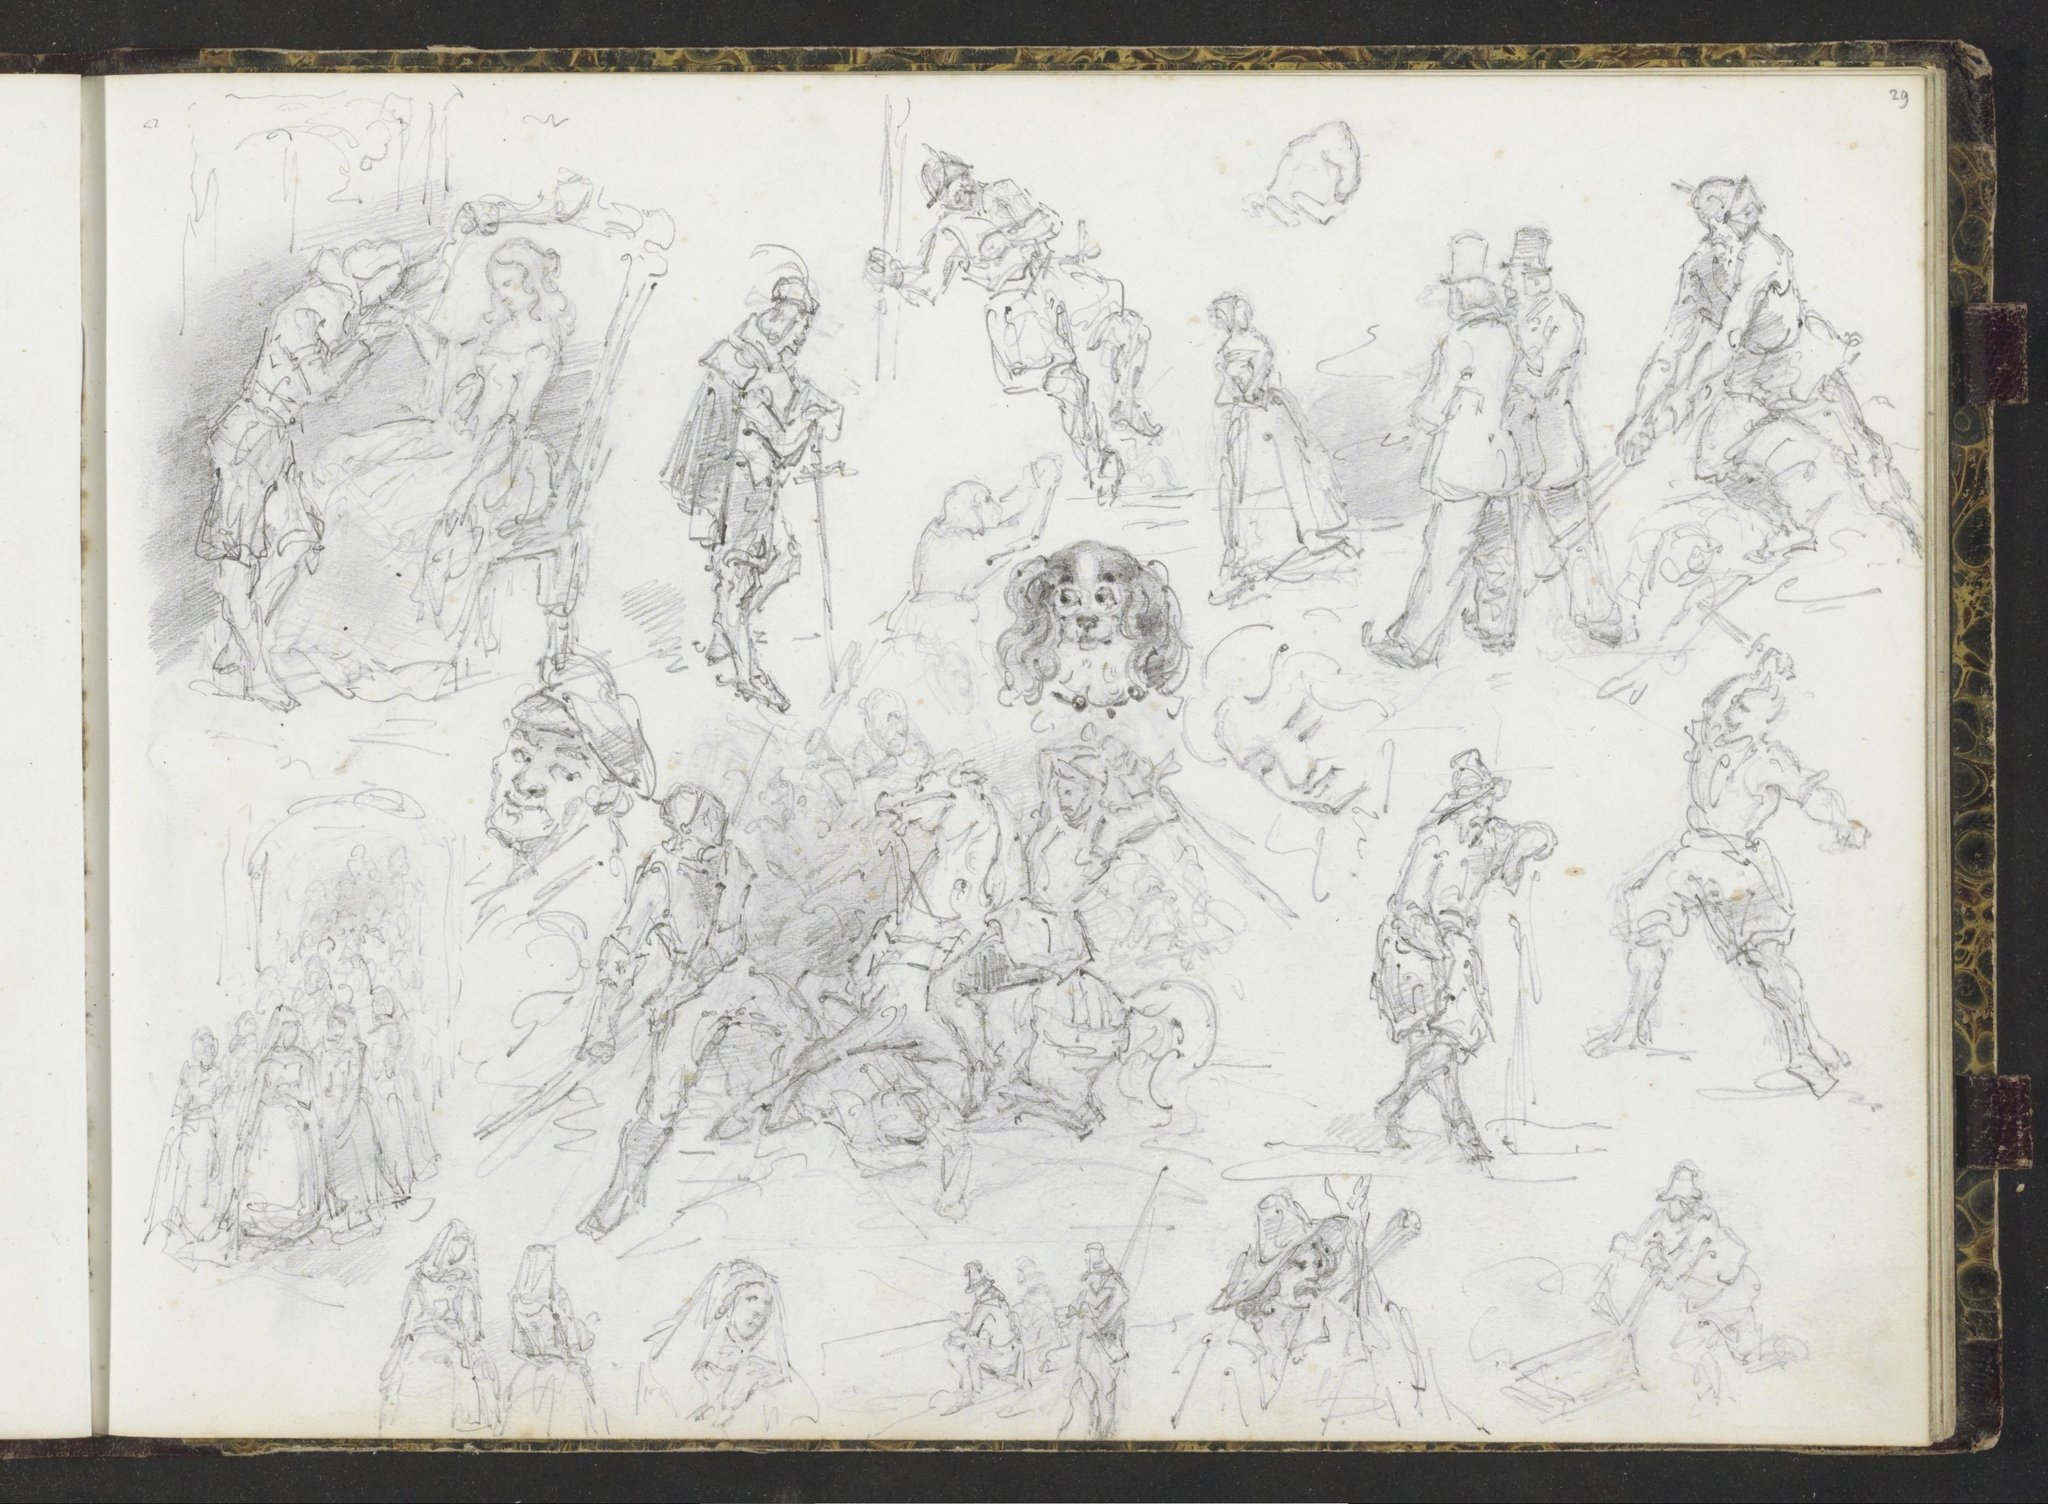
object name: sketchbook leaf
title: Studieblad met een liefdespaar, nonnen en een ruitergevecht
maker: lambertus lingeman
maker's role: draughtsman, painter, print maker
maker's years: 1829-1894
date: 1839-1894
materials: paper, pencil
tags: nun(s), battle, the soldier; the soldier's life, couple of lovers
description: Tevens studies van koppen, vissers, een man met een slee en een hond. Blad 29 recto uit een schetsboek met 51 bladen.